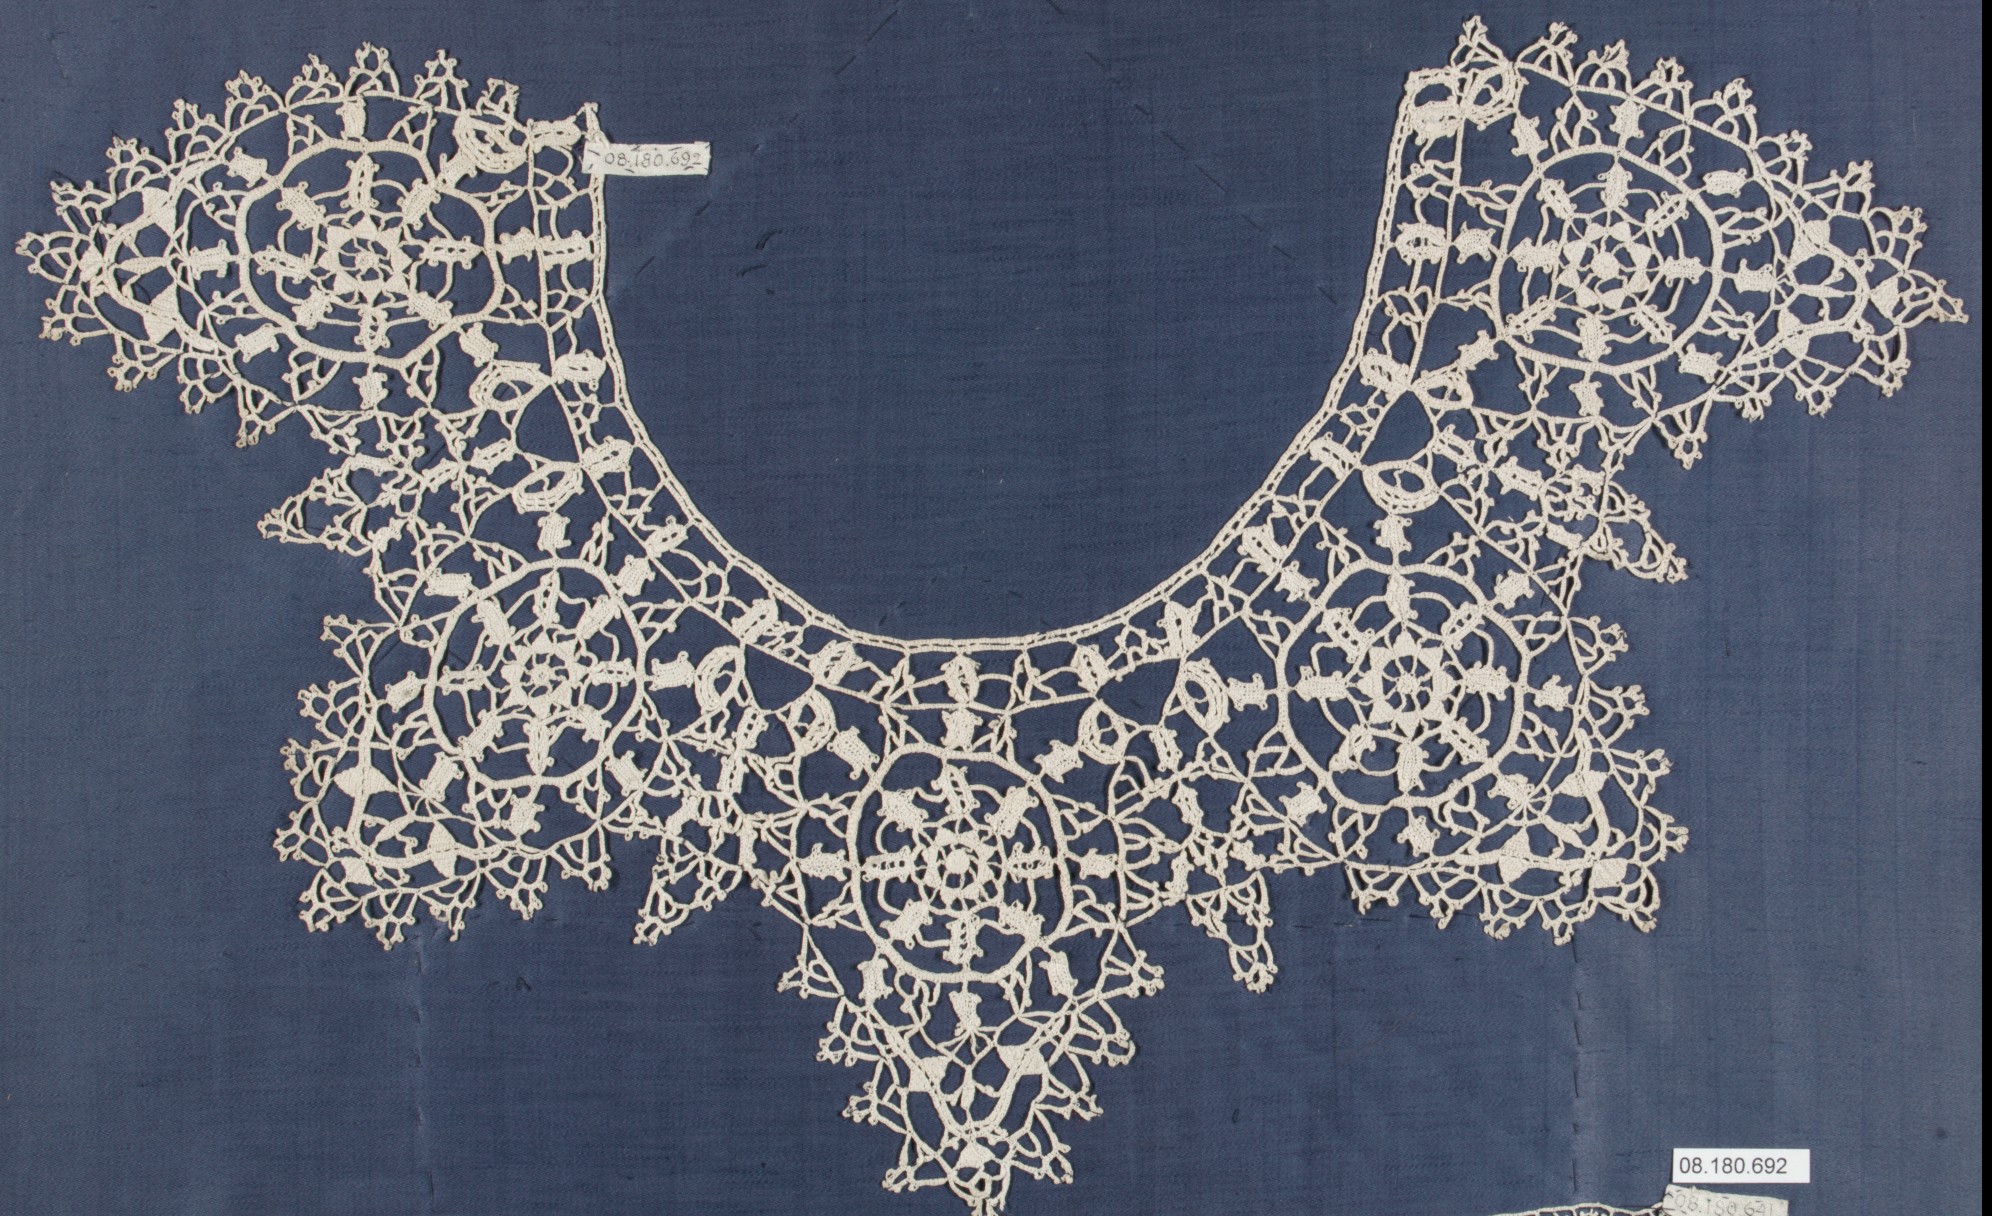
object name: collar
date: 1701-1800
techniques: crochet